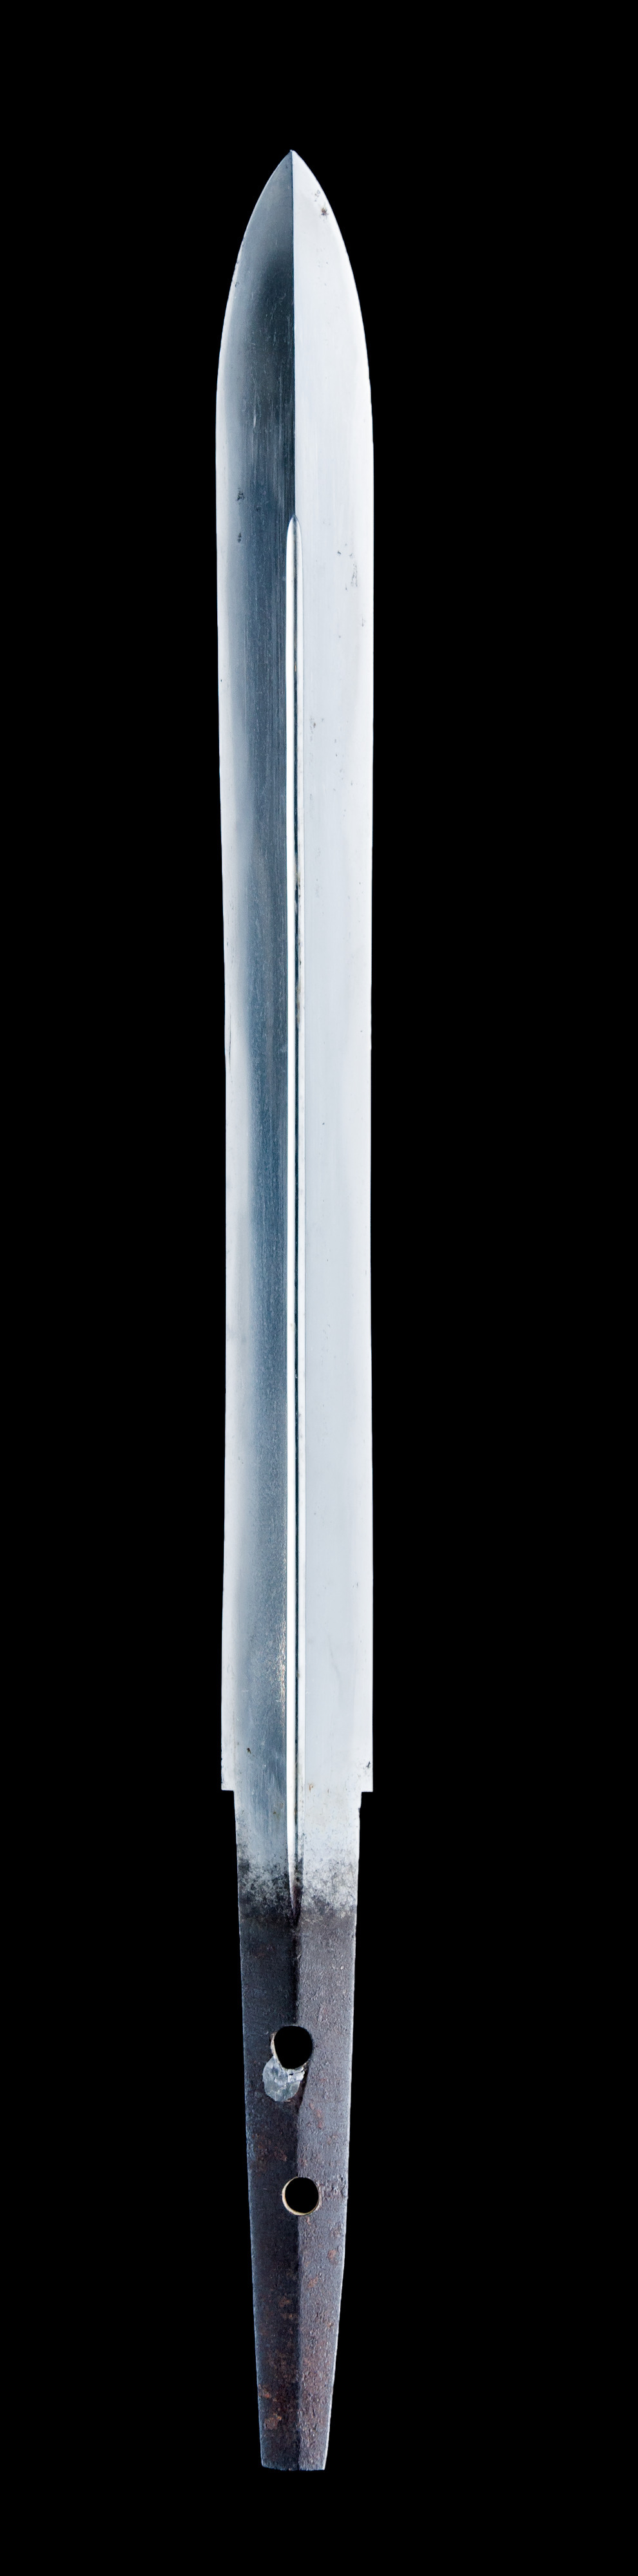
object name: blade and mounting for a double edged dagger ken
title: Blade and Mounting for a Double-Edged Dagger (Ken)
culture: japanese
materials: brass, gold alloy, gold, lacquer, silver, steel, wood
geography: japan